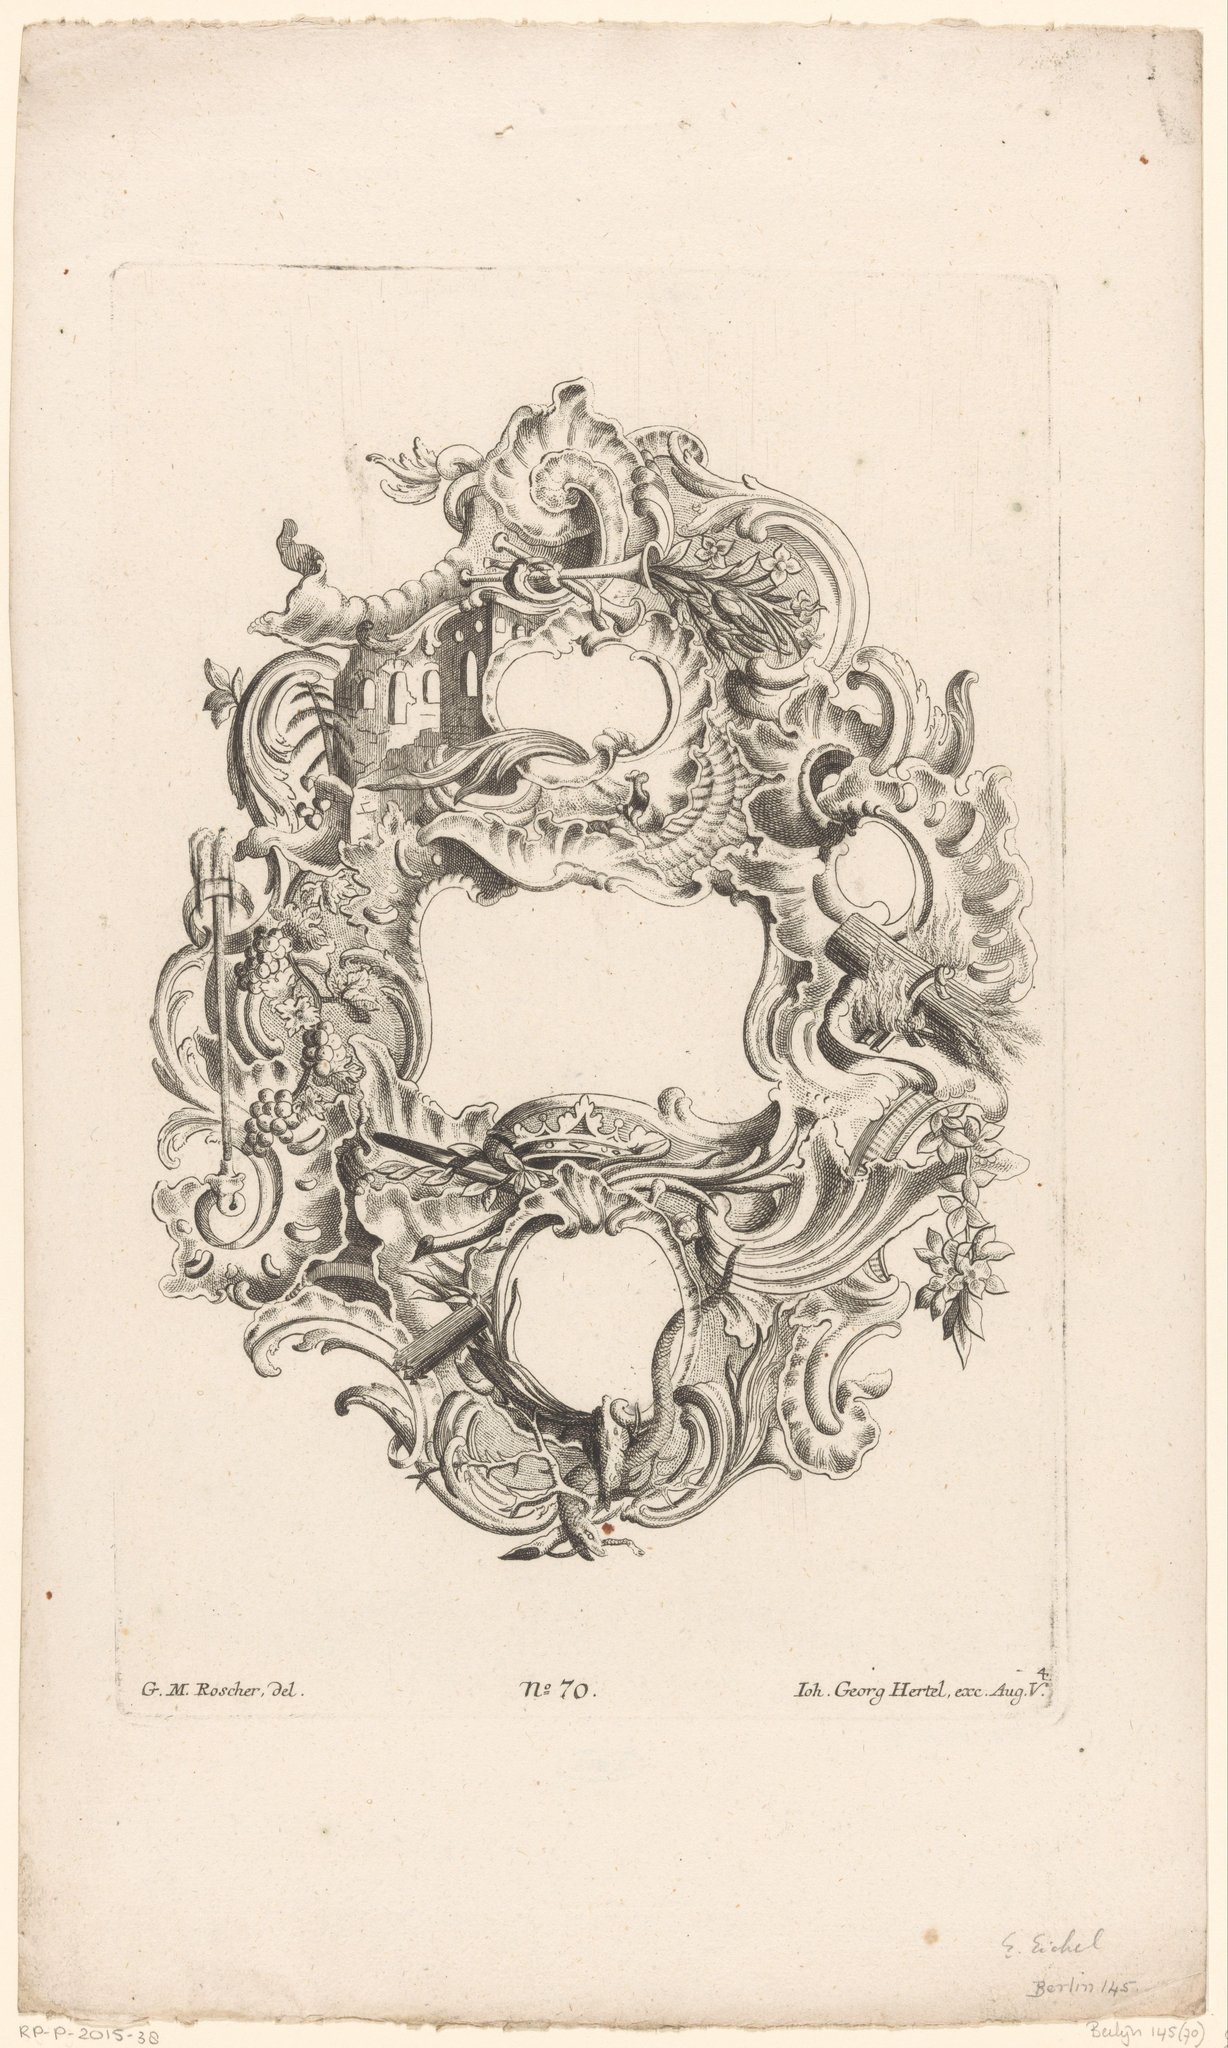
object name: ornament print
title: Cartouche met kroon en slang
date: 1727-1775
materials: paper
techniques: etching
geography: augsburg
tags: crown (symbol of sovereignty), snakes, vine-tendril, leaf, archer's weapons: arrow, ornament ~ cartouche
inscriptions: collector's mark: Lugt 2228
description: Rocaille cartouche met slang, kroon, een bundel pijlen, druivenranken, bazuinen, een graanbundel met vuur en blad- en bloemmotieven. Uitgeversnummer 70.